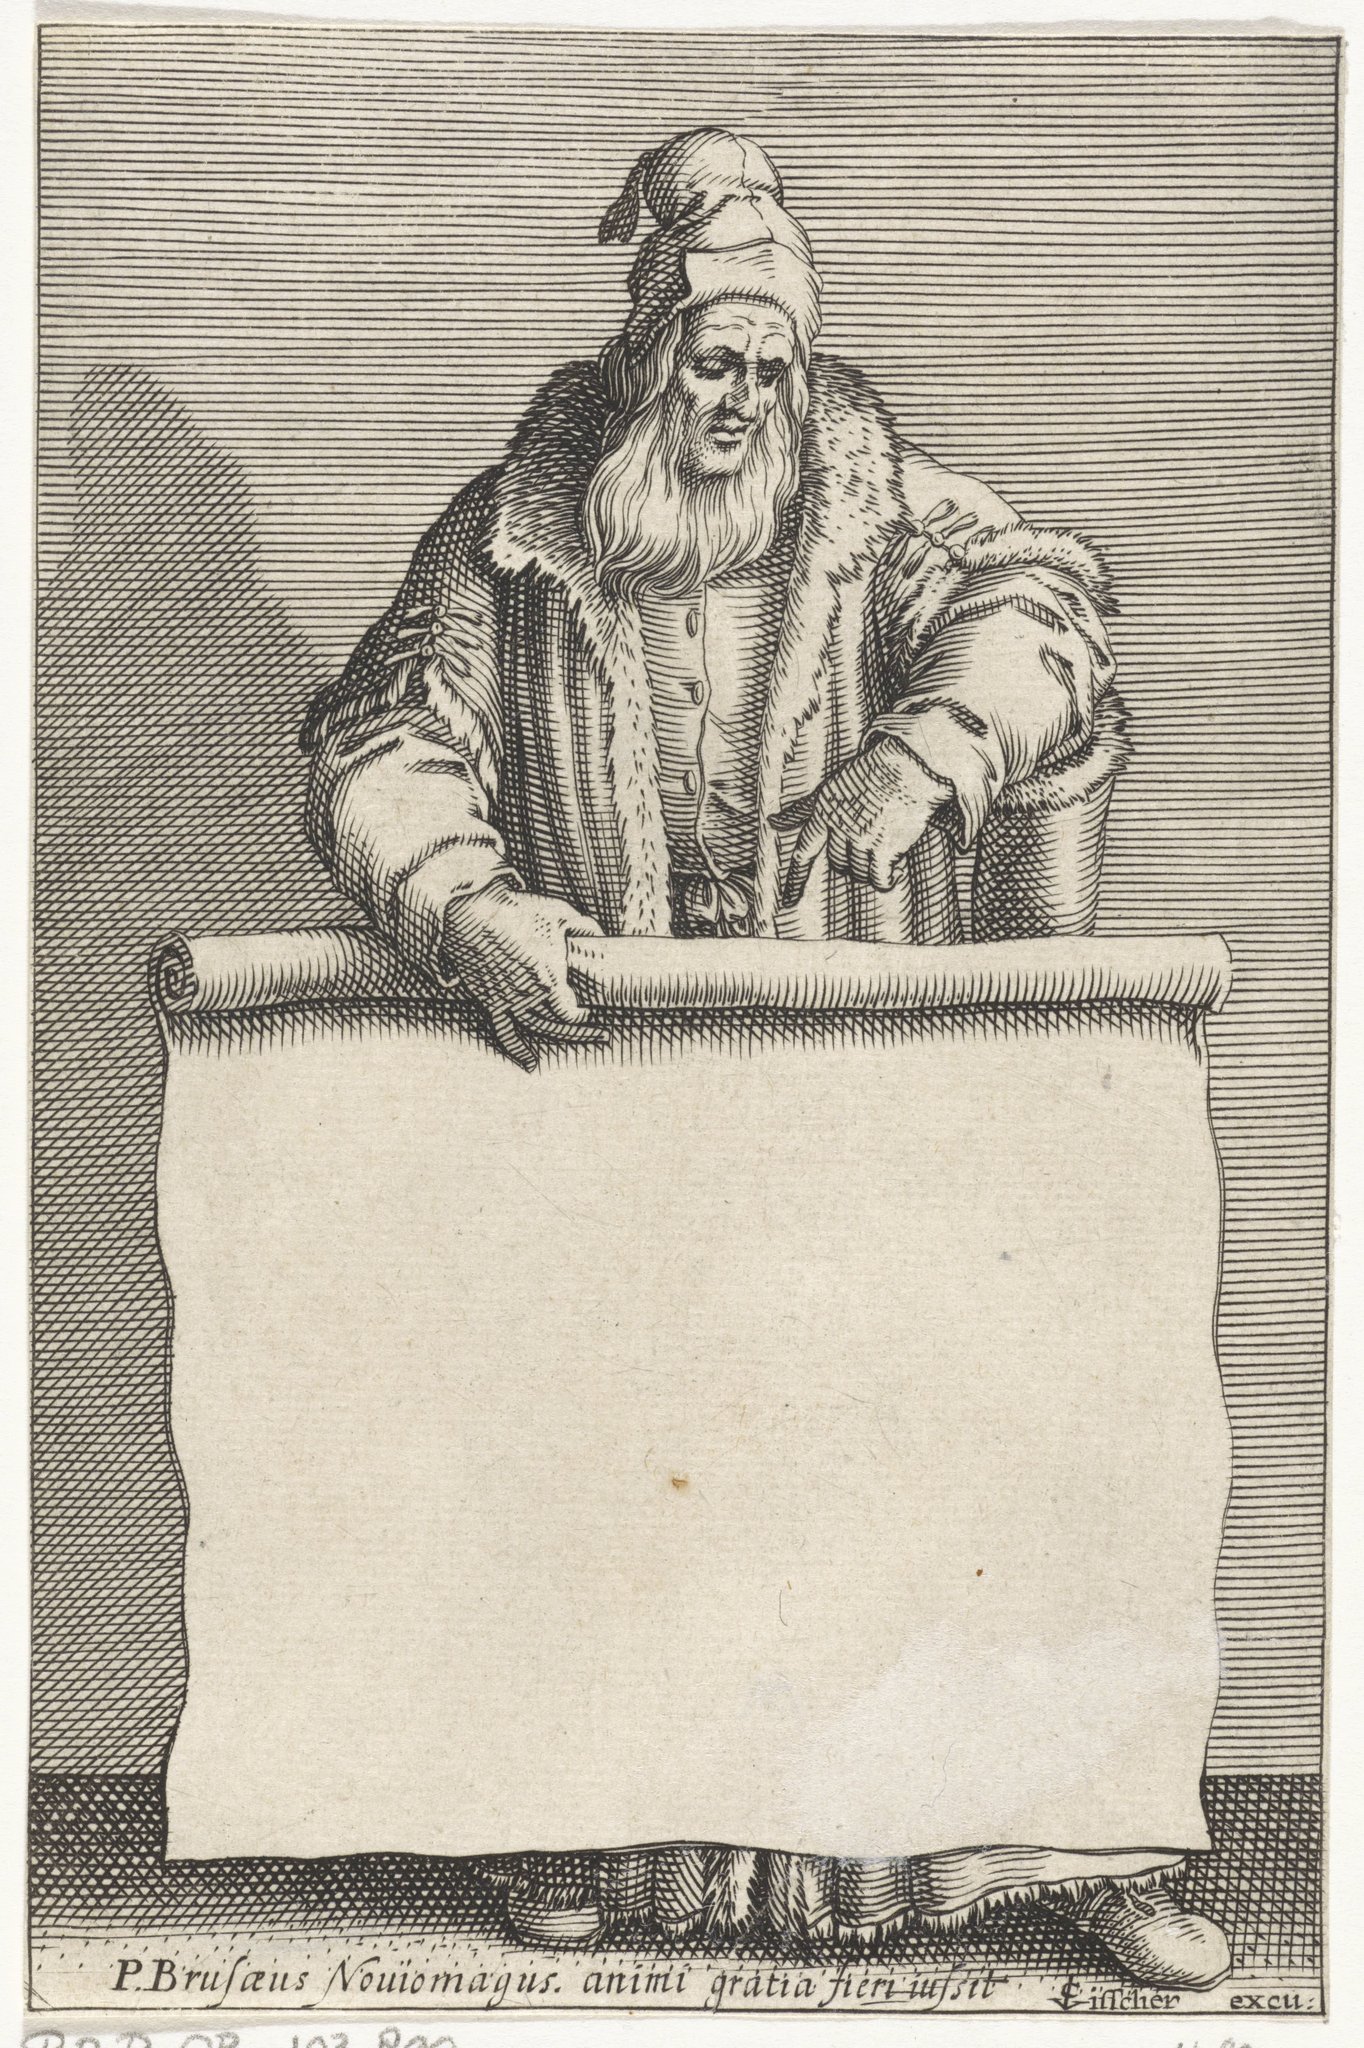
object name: print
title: Oude man met rol papier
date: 1601-1657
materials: paper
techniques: engraving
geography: amsterdam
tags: scroll - ll - scroll unfolded, old man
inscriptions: collector's mark: Lugt 240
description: Oude man met baard en bontkraag met een uitgerolde boekrol in de hand. Hij wijst met zijn vinger op het onbeschreven schrijfvlak.